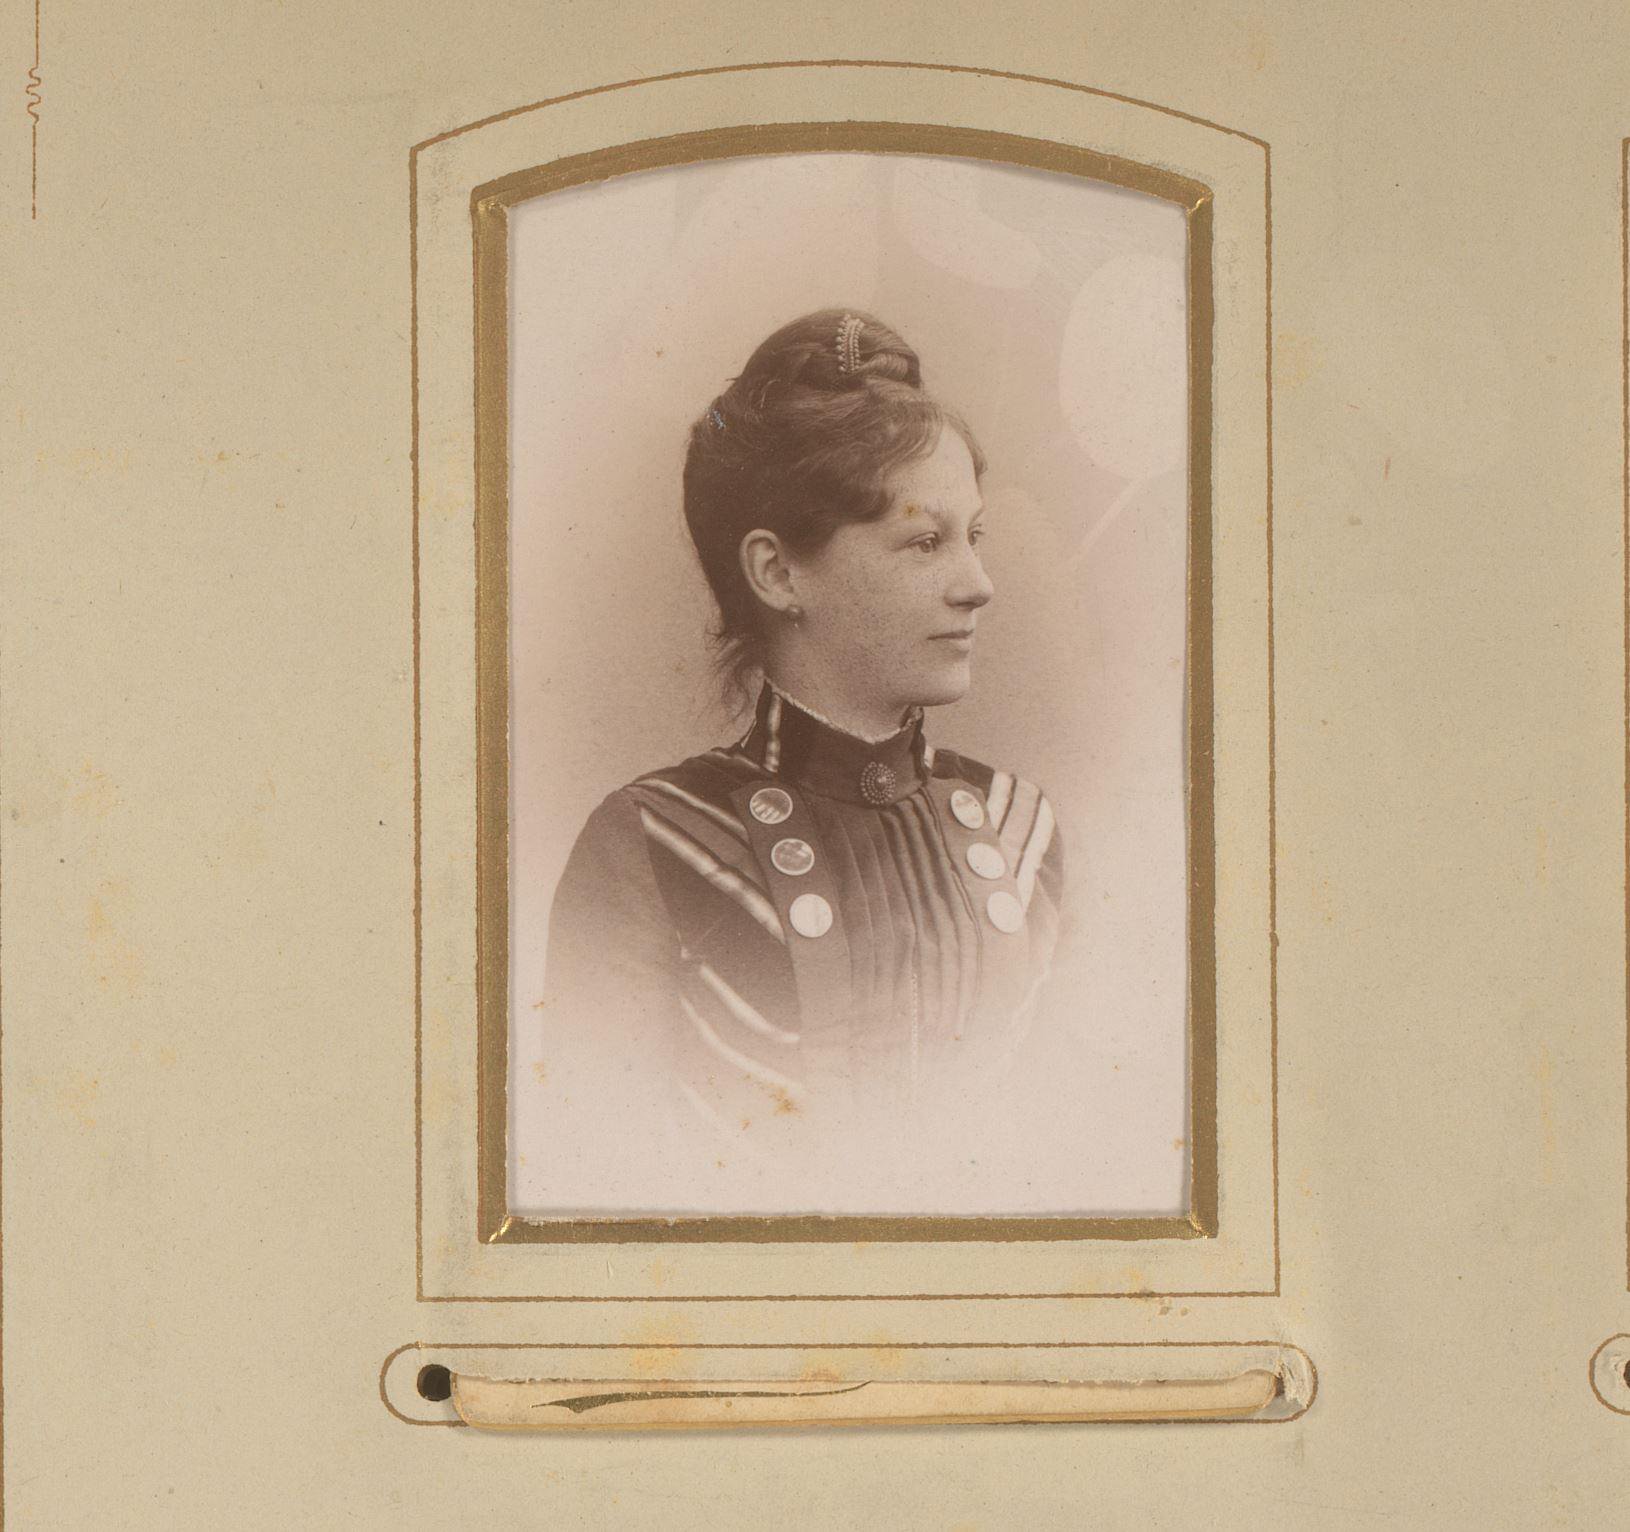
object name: photograph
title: Portret van een jonge vrouw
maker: paul strnad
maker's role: fotograaf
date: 1870-1900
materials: cardboard, photographic support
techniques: albumen print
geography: erfurt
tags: adolescent, young woman, maiden, historical persons - bb - woman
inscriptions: inscription: ‘Paul Strnad/ Erfurt/ Anger No 43/ Die Platte bleibt aufbewahrt./ Vergrösserungen bis zur Lebensgrösse und colorirte/ Photographien werden künstlerisch ausgeführt.’